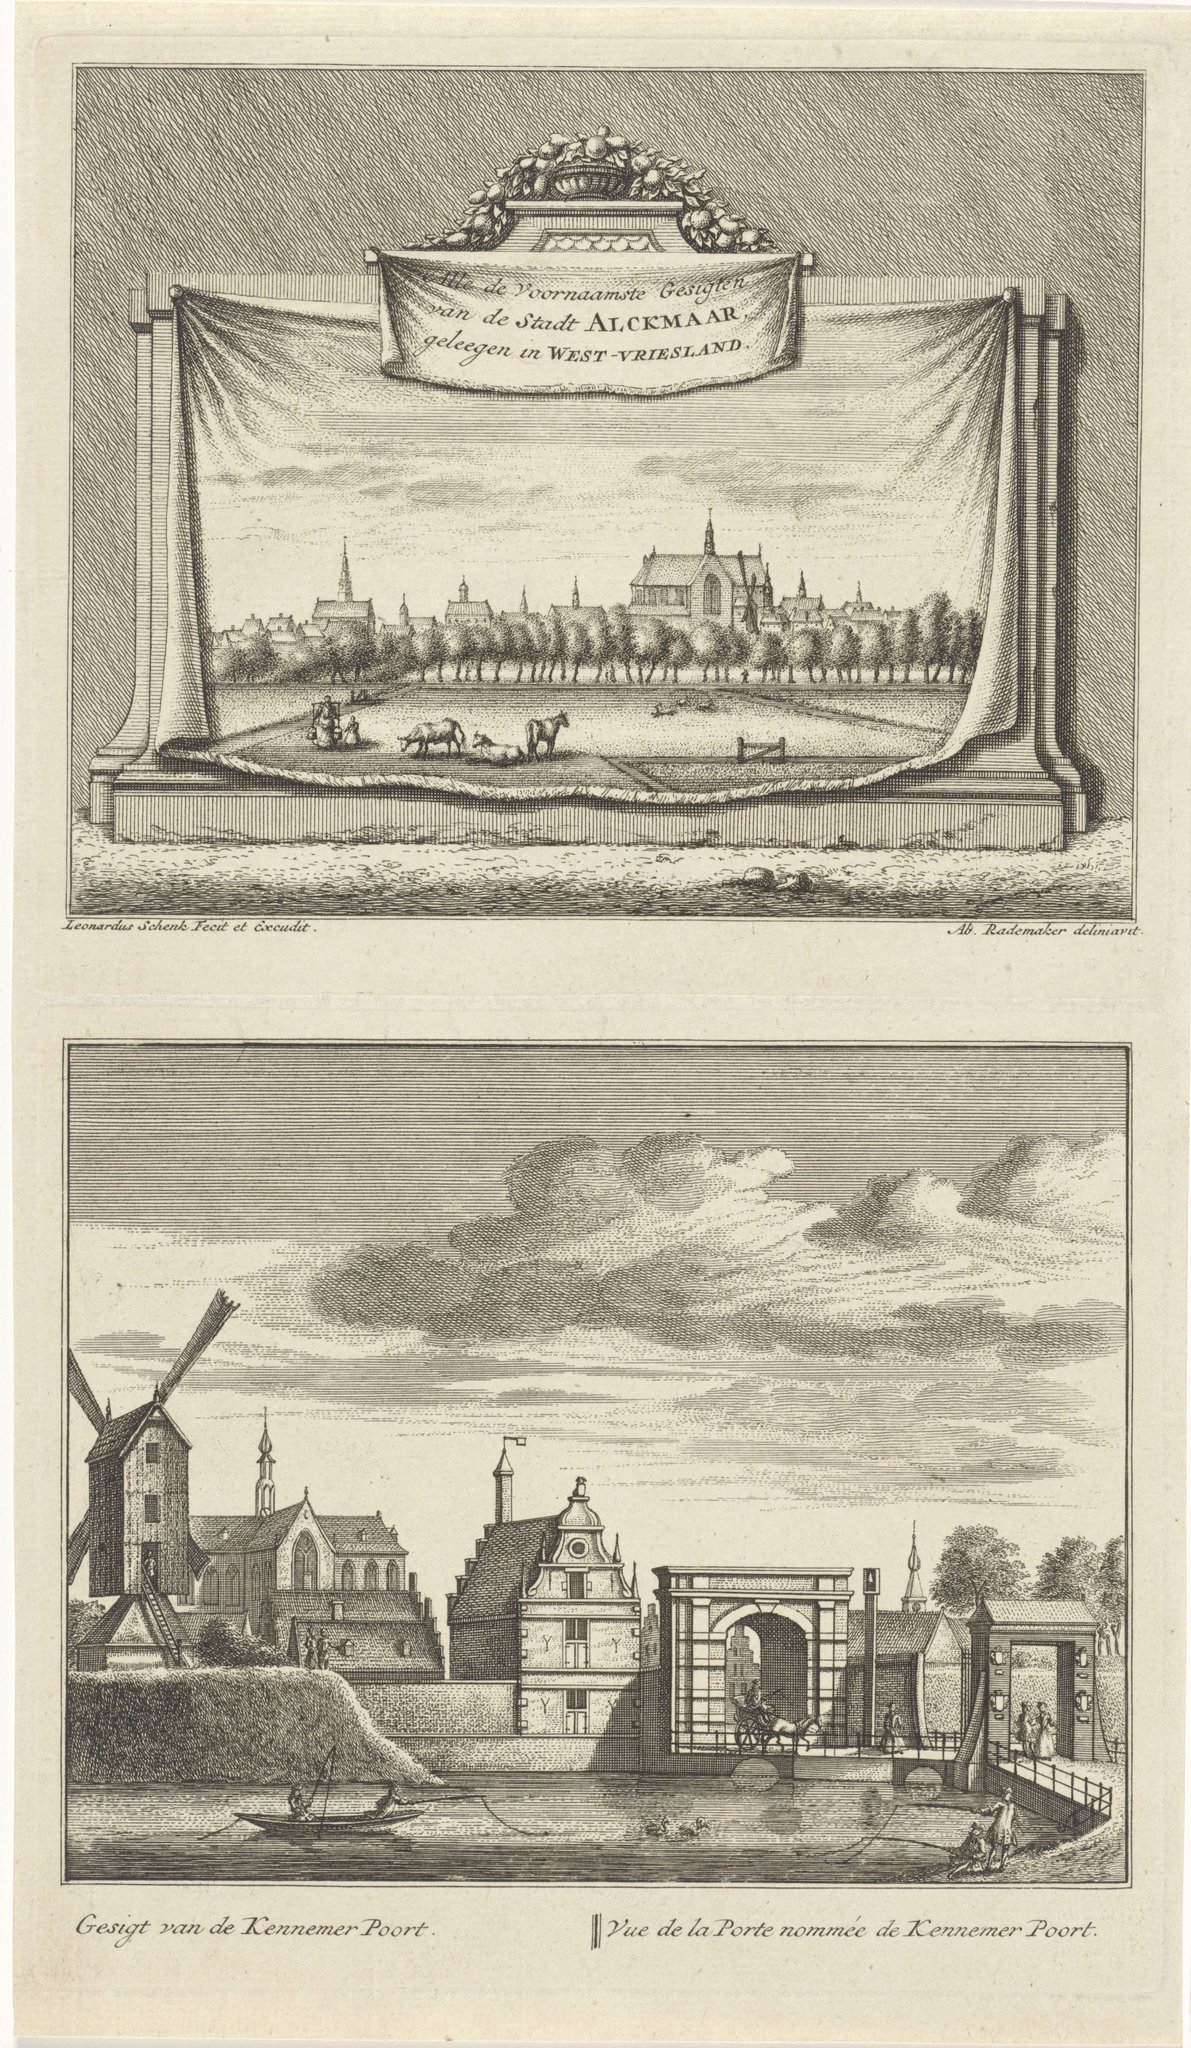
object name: print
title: Gezichten op Alkmaar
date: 1746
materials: paper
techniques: etching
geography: amsterdam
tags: cattle, windmill, city-gate, city-view, and landscape with man-made constructions (+ city(-scape) with figures, staffage)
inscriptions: collector's mark: Lugt 2228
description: Op de bovenste prent een weiland met koeien en ander vee. Links loopt een vrouw met een houten juk met daaraan twee emmers. Naast haar wandelt een kind. In de verte ligt Alkmaar met rechts de Grote Kerk. Op de onderste prent staat een houten molen langs een kanaal. Rechts de Kennemerpoort en linksachter de Grote Kerk. Onder de voorstelling de titel in het Nederlands en Frans.